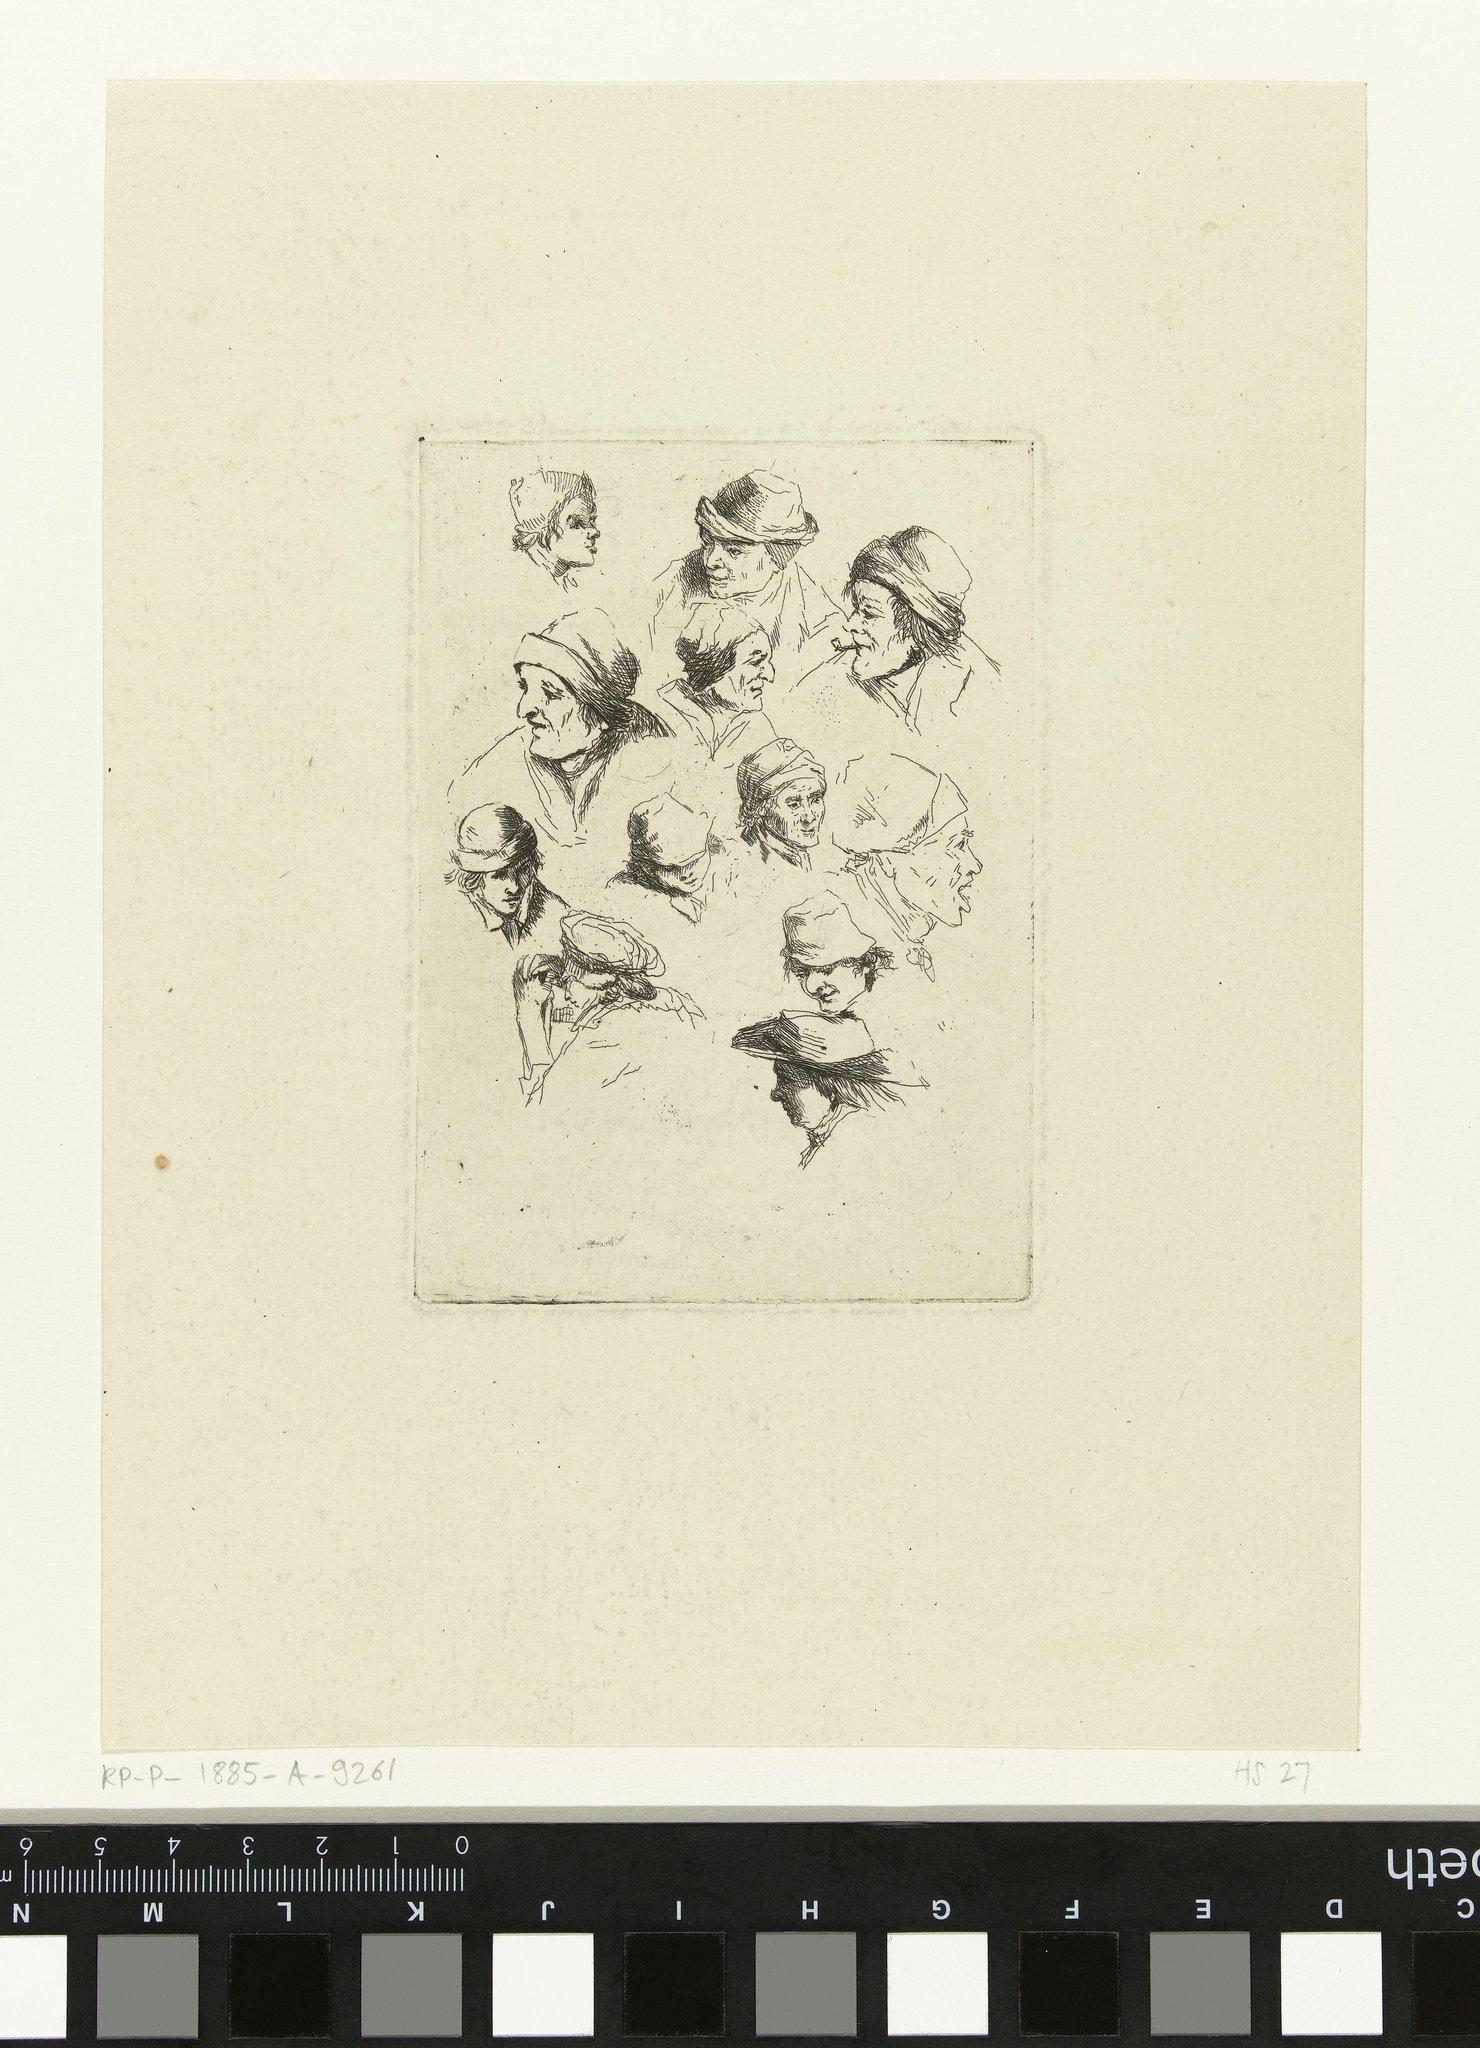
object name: print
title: Studieblad met twaalf hoofden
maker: marie lambertine coclers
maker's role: conservator, draughtsman, print maker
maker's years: 1761-1815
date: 1776-1815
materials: paper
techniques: etching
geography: amsterdam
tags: pipe ~ tobacco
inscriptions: collector's mark: Lugt 2228